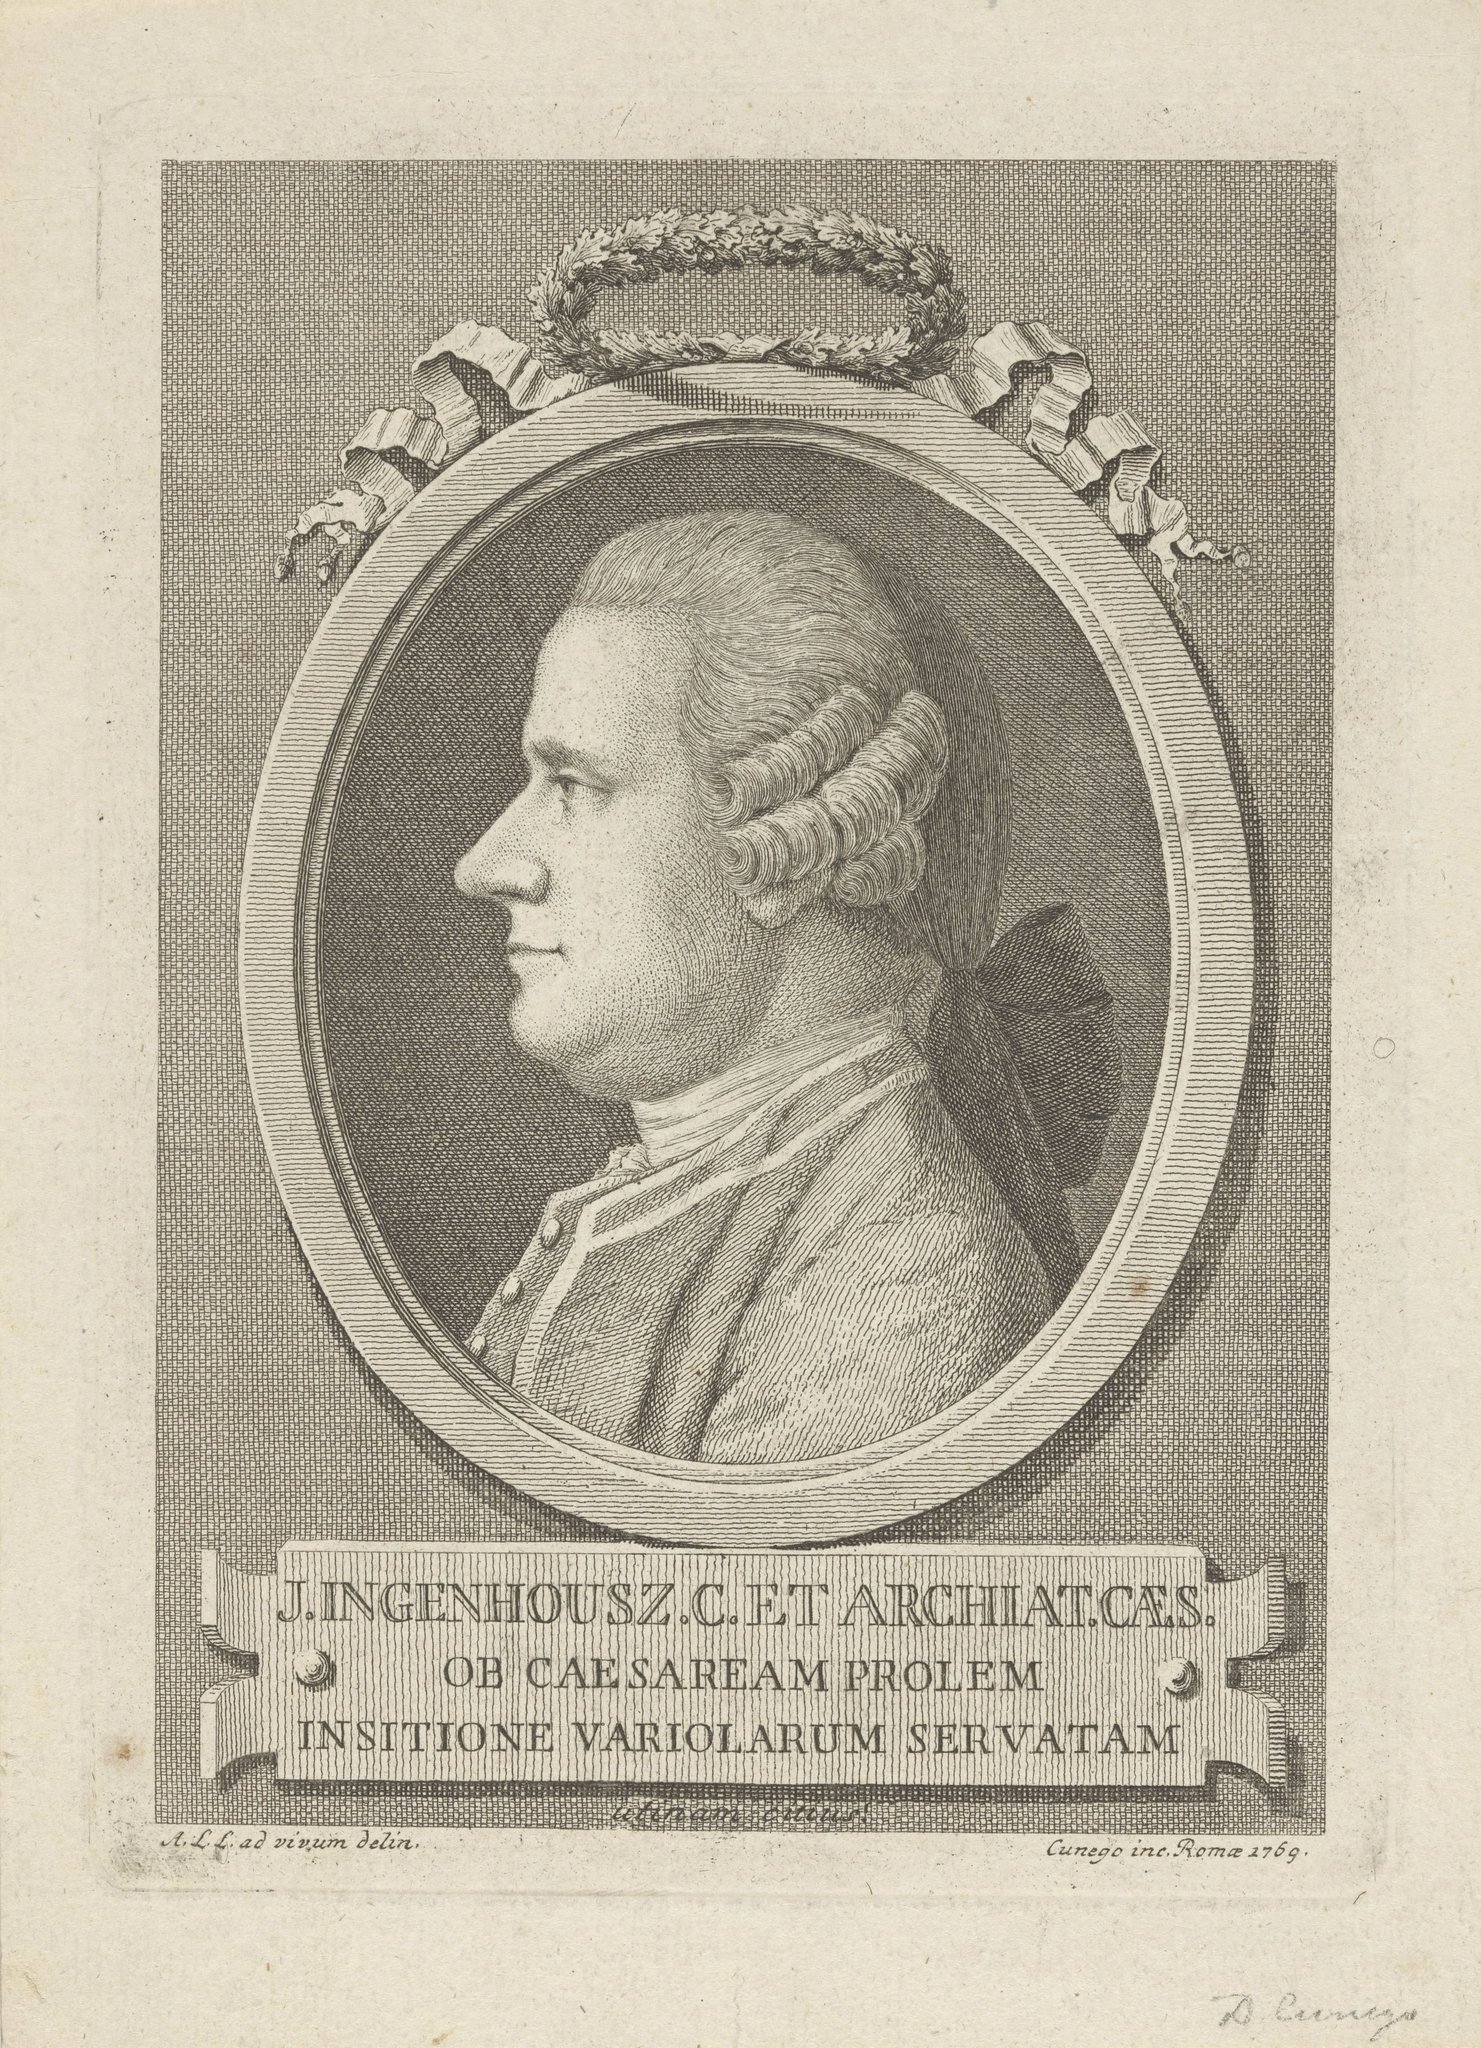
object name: print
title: Portret van bioloog en arts Jan Ingenhousz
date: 1769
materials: paper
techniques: engraving, etching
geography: rome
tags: england, historical persons, science and technology (+ portrait of scholar, scientist)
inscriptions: collector's mark: Lugt 2228